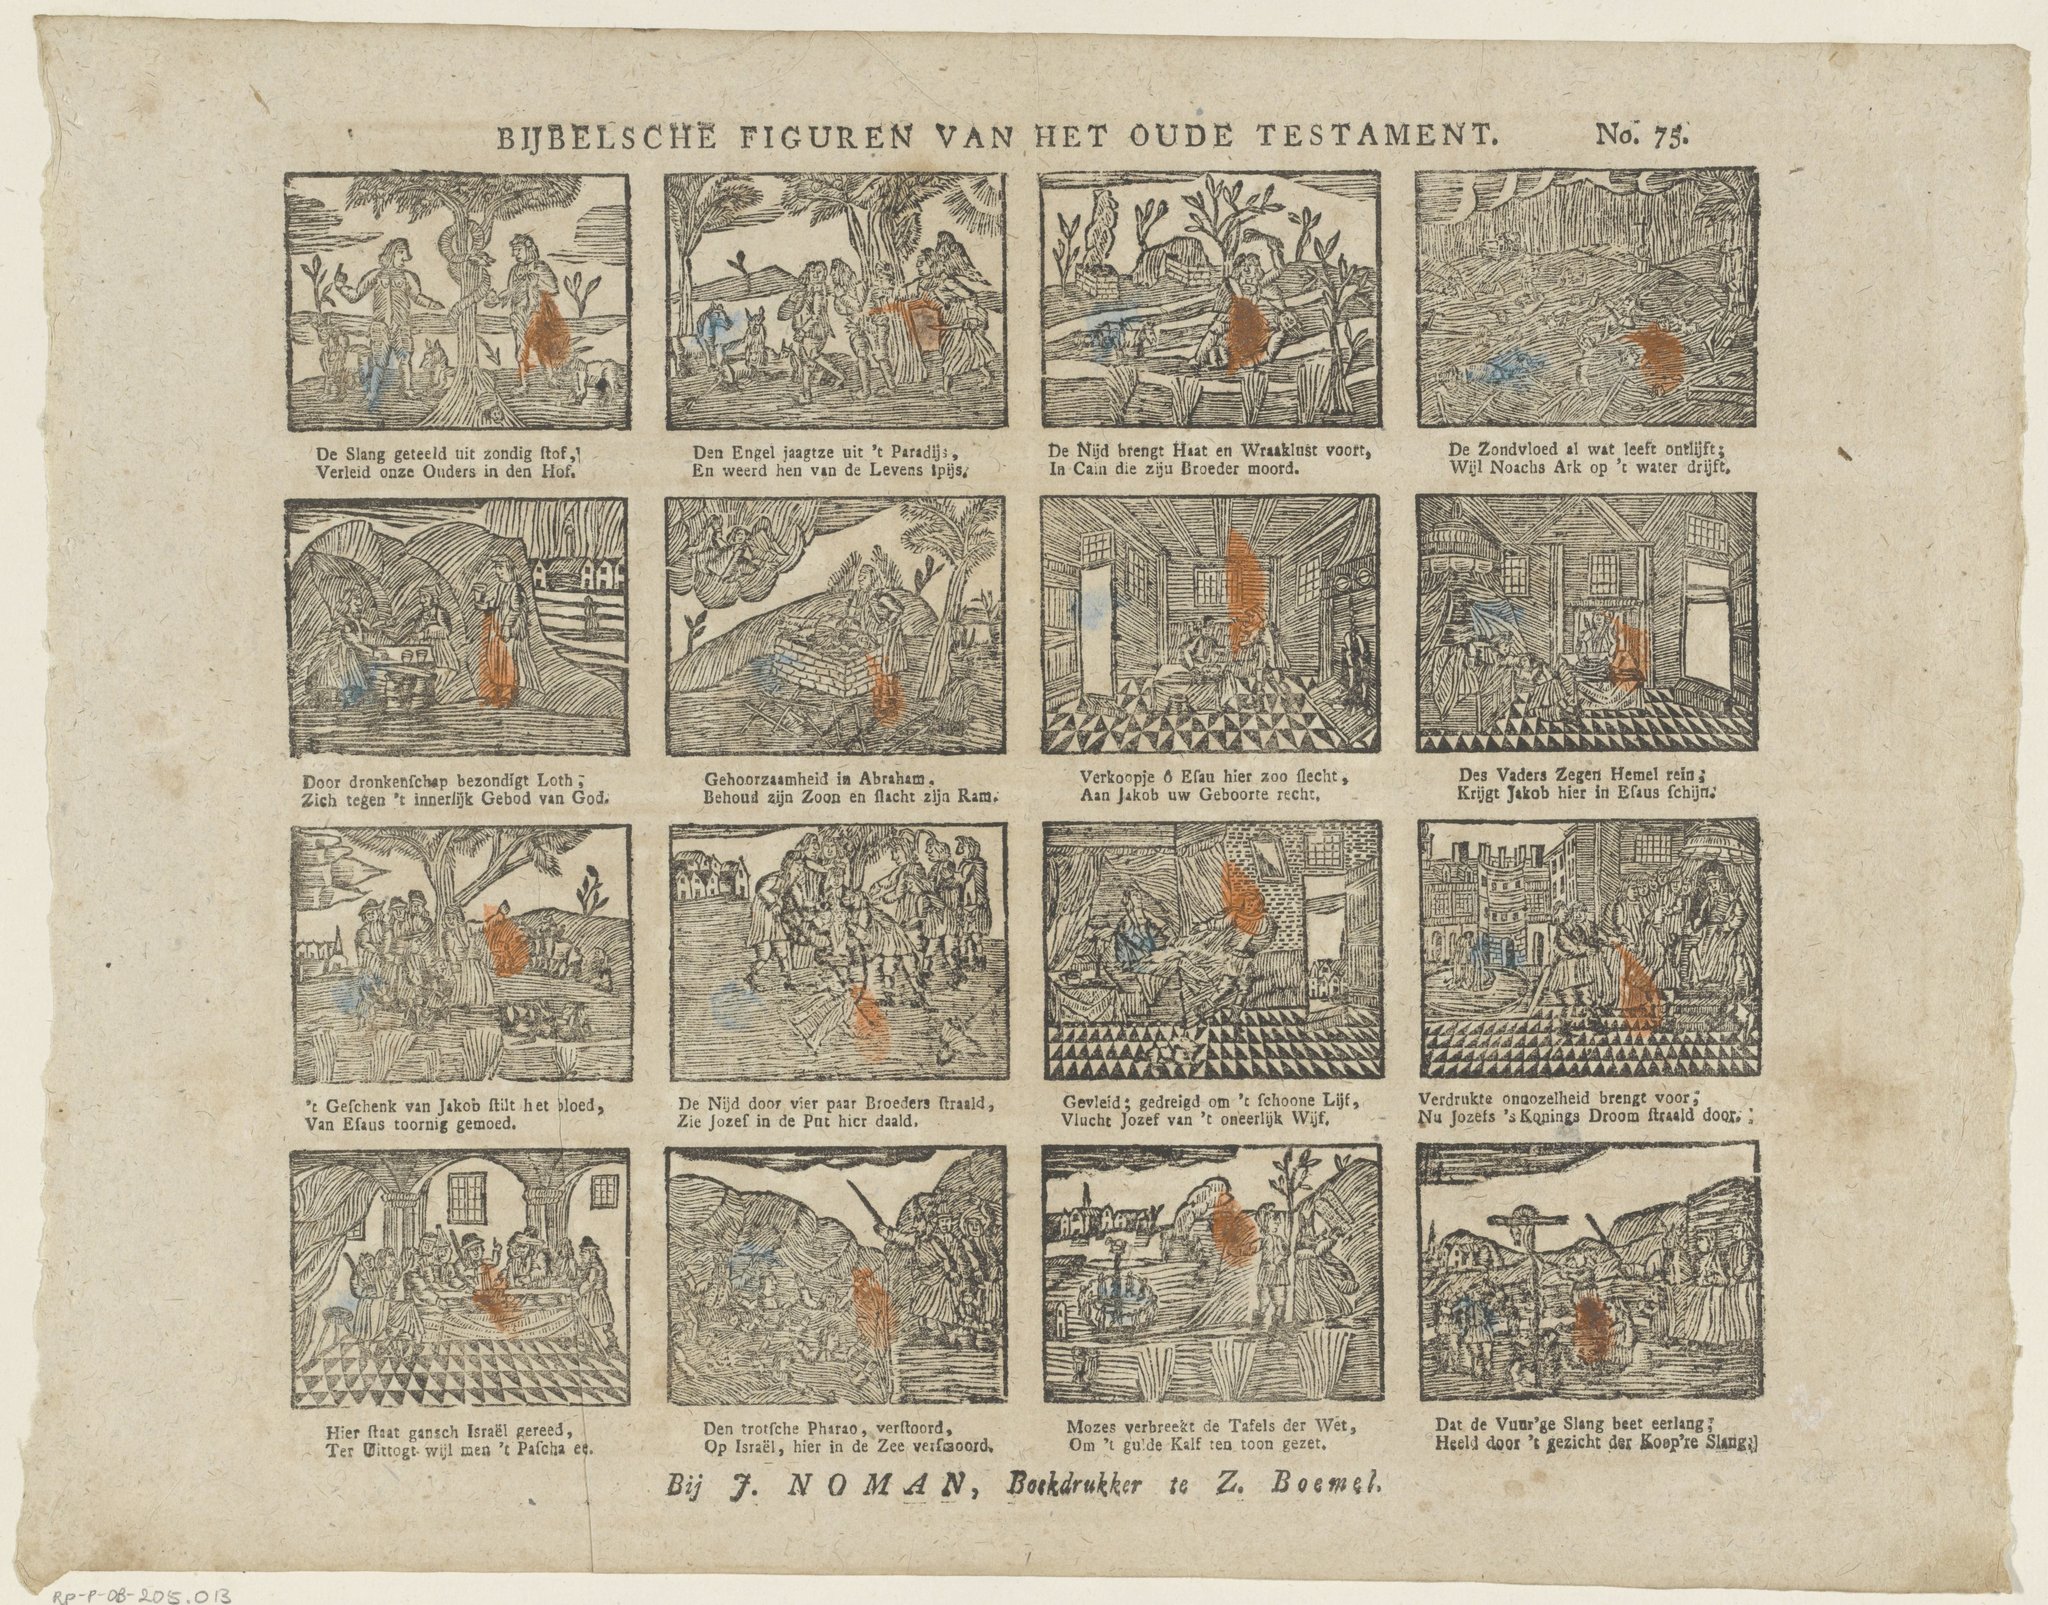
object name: print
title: Bijbelsche figuren van het Oude Testament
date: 1806-1830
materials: paper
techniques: colour, letterpress printing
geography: netherlands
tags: old testament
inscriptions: collector's mark: Lugt 2760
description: Blad met 16 voorstellingen van verhalen uit het Oude Testament, zoals de verdrijving van Adam en Eva uit het paradijs en Mozes die de tafelen der wet breekt. Onder elke afbeelding een tweeregelig vers. Genummerd rechtsboven: No. 75.